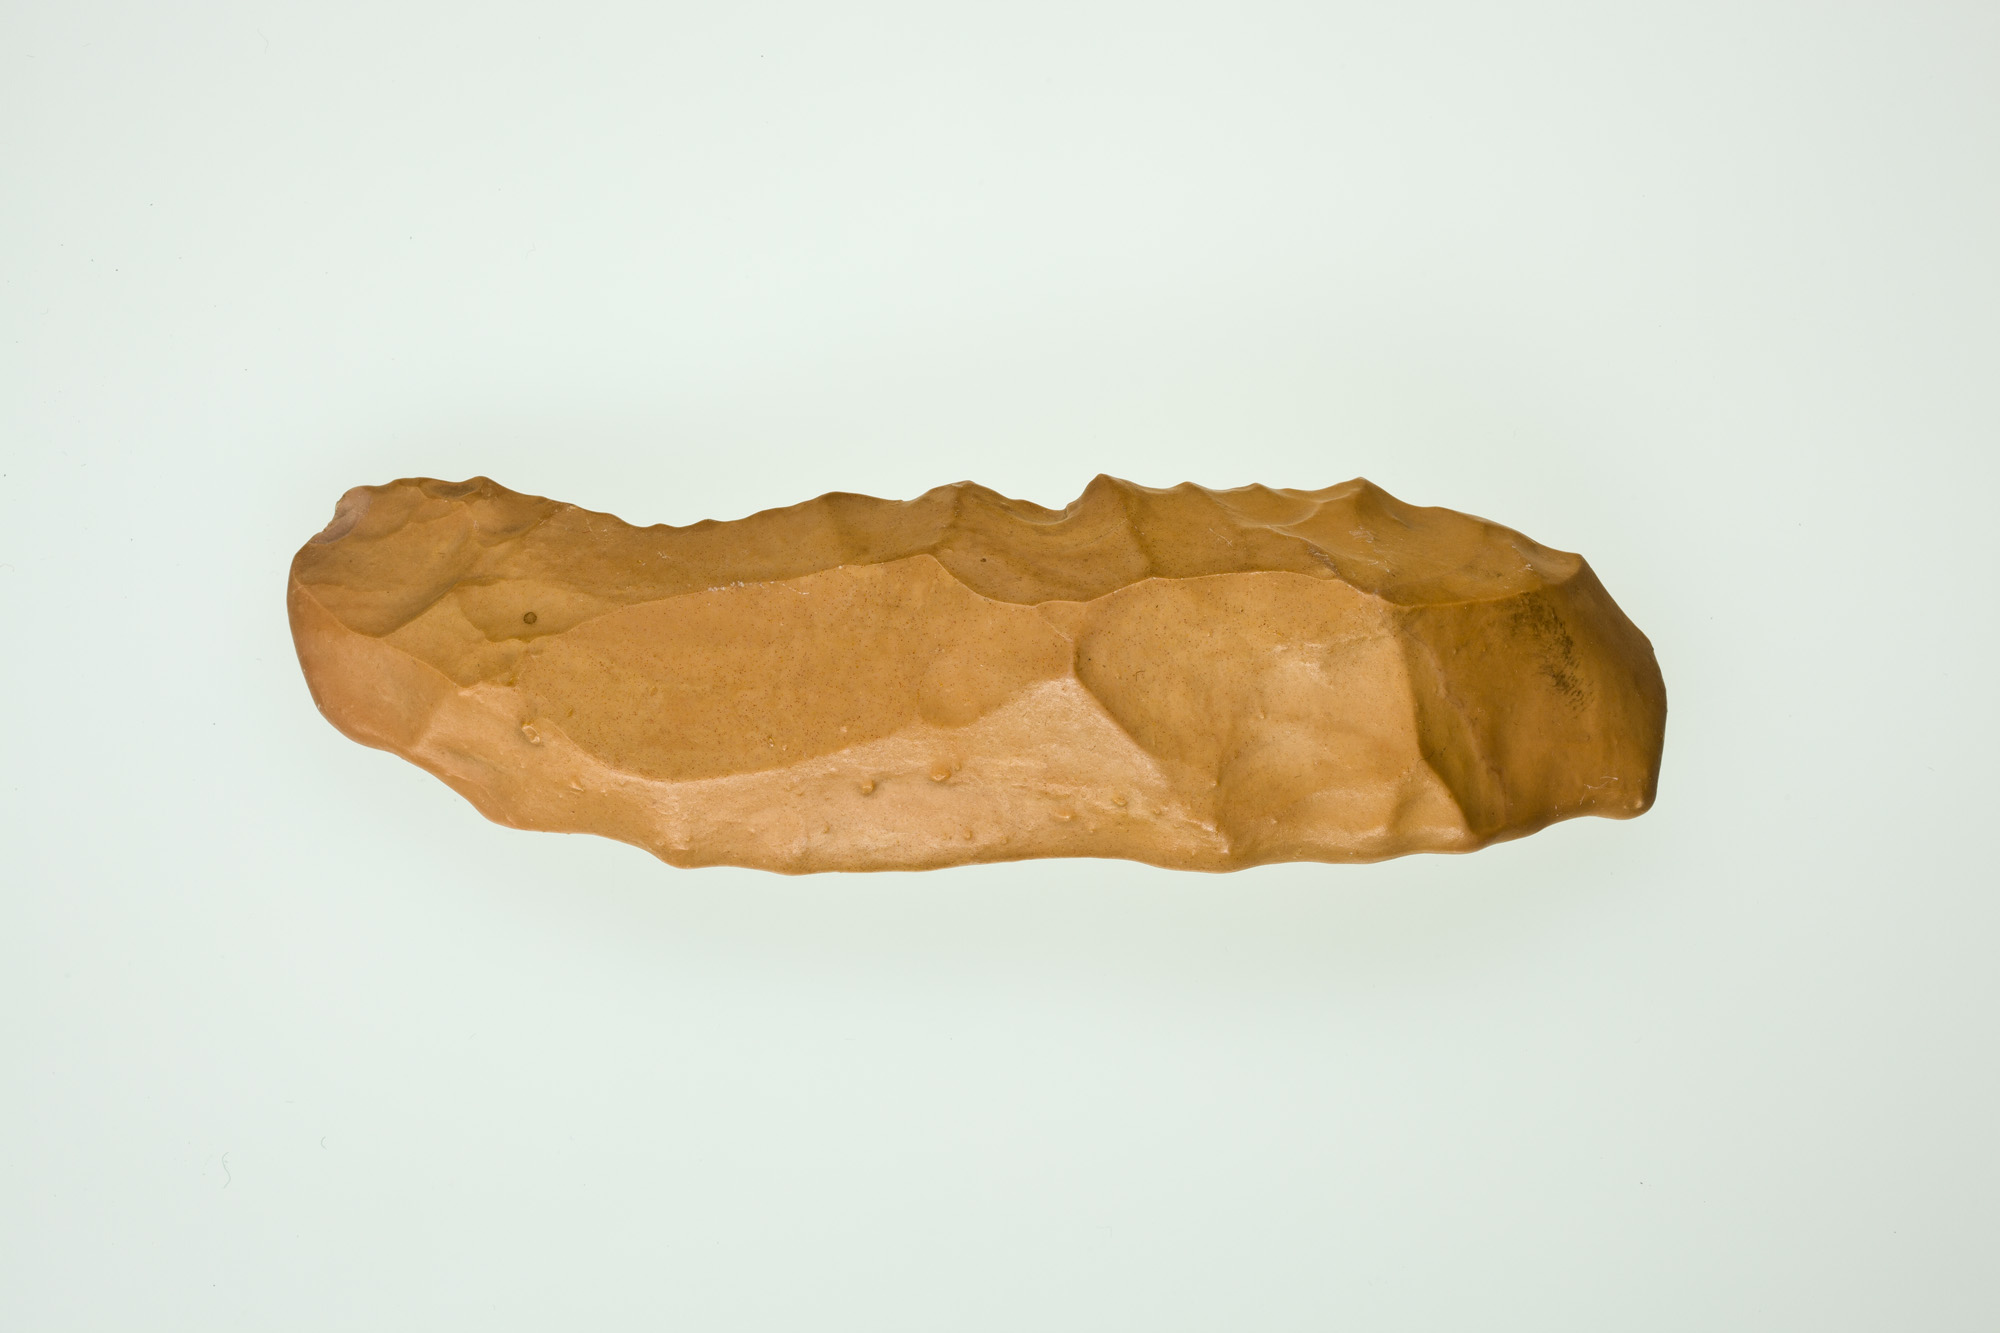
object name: tool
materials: stone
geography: egypt